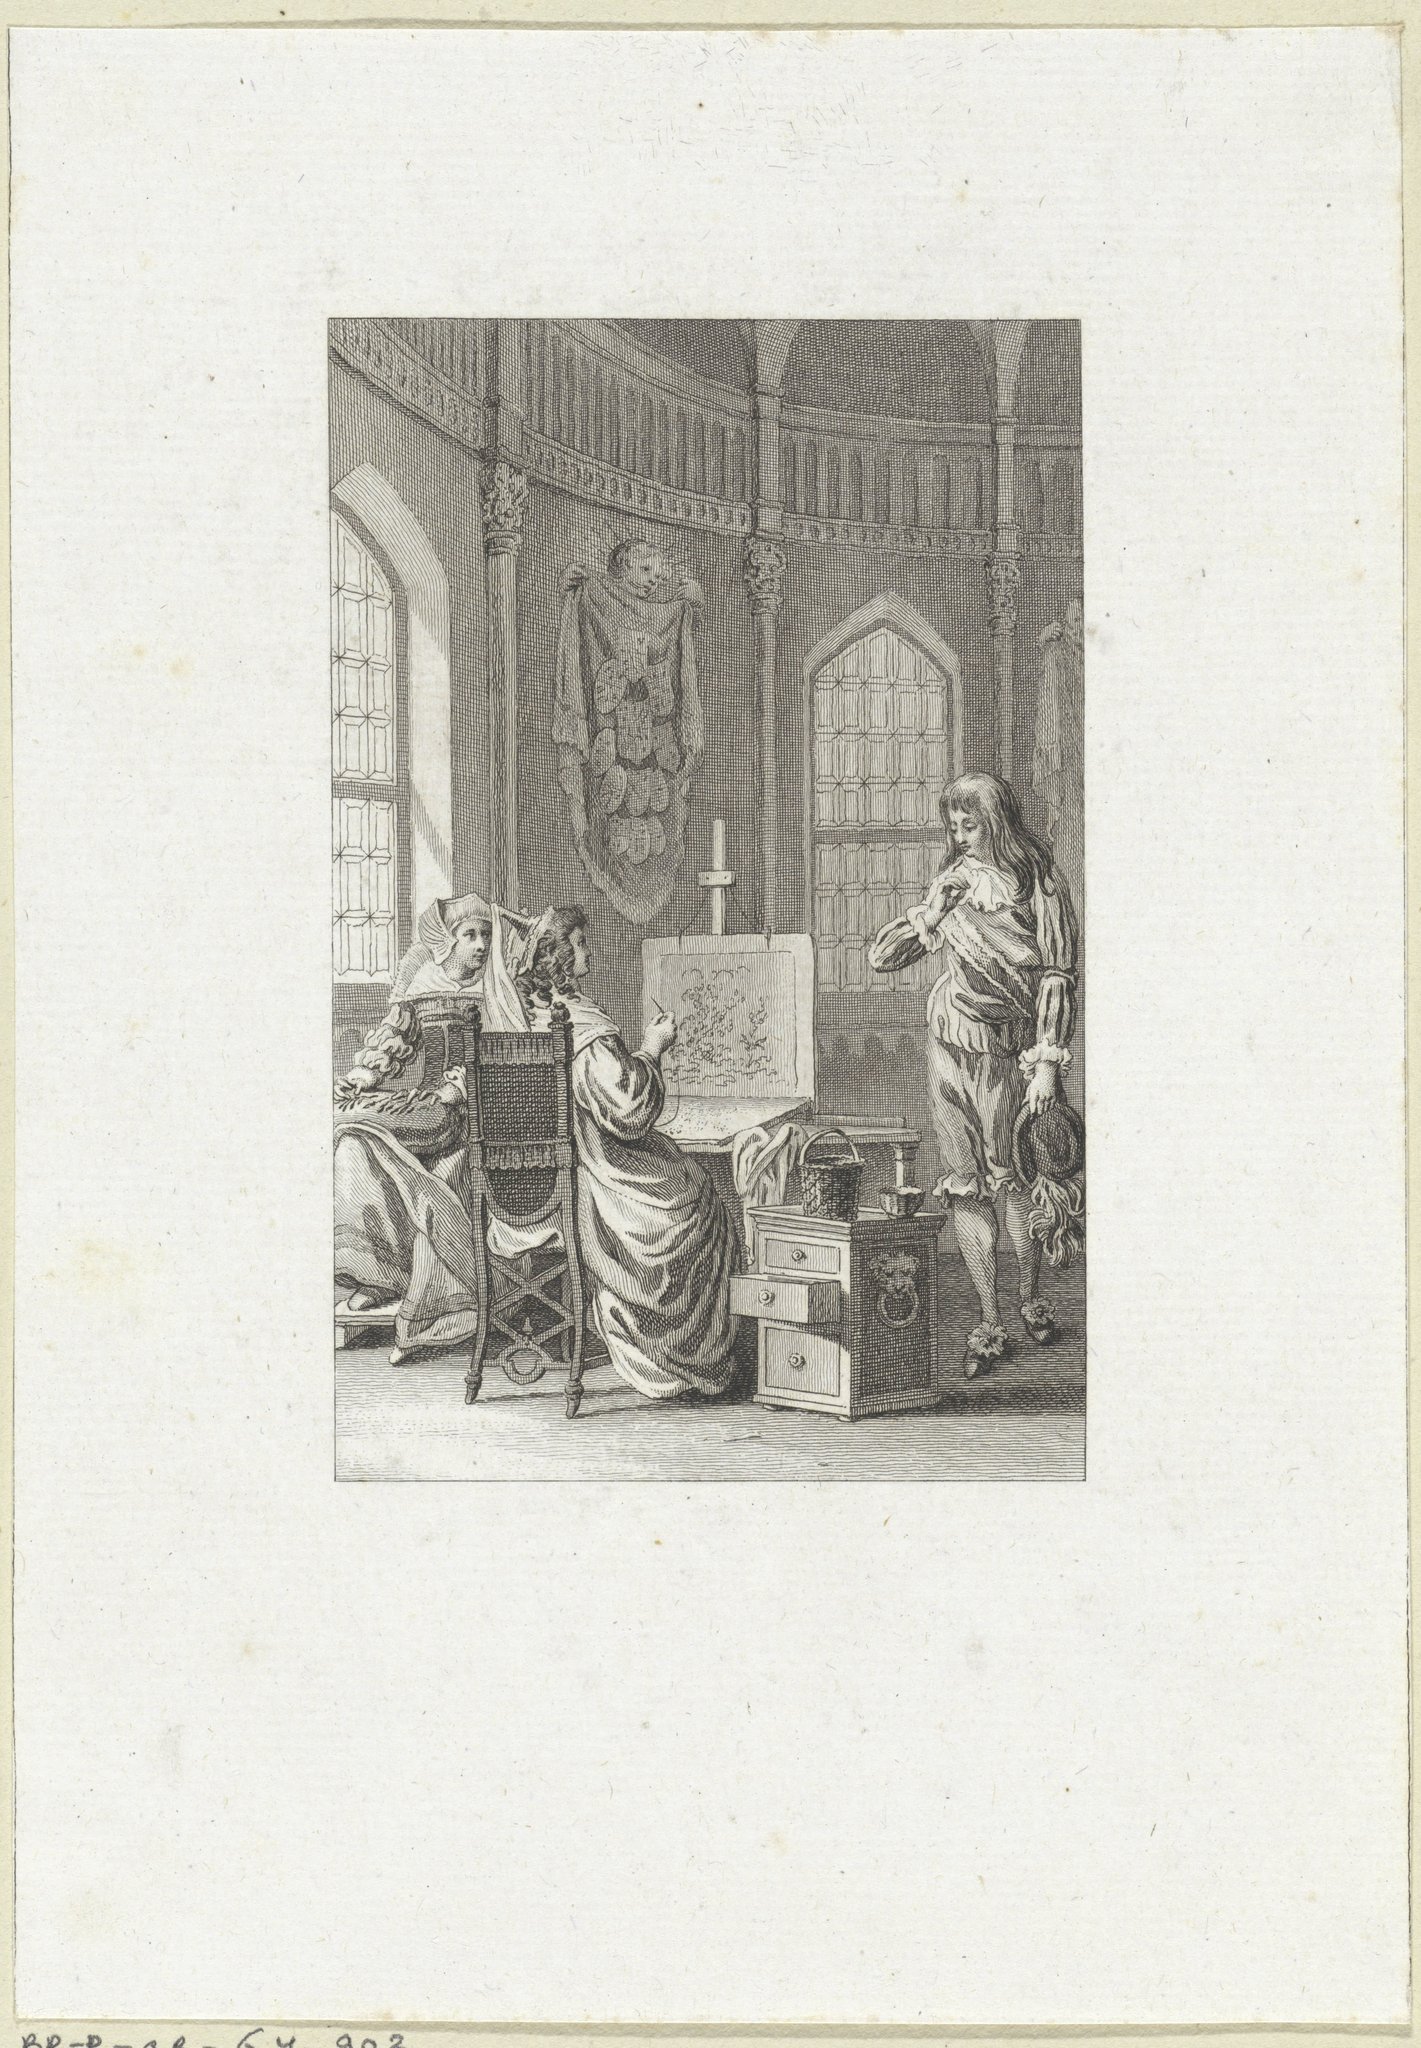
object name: print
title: Twee handwerkende dames in gesprek met een heer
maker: reinier vinkeles (i)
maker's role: draughtsman, print maker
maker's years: 1741-1816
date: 1795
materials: paper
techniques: engraving, etching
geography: amsterdam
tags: conversation, dialogue; conversation piece, sewing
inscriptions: collector's mark: Lugt 240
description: Illustratie bij het verhaal 'Sargines' in: Baculard d'Arnaud, François Thomas Marie de. Zedelyke verhaalen, deel 14. Amsterdam: Erven van Pieter Meyer en Gerrit Warnars, 1795.